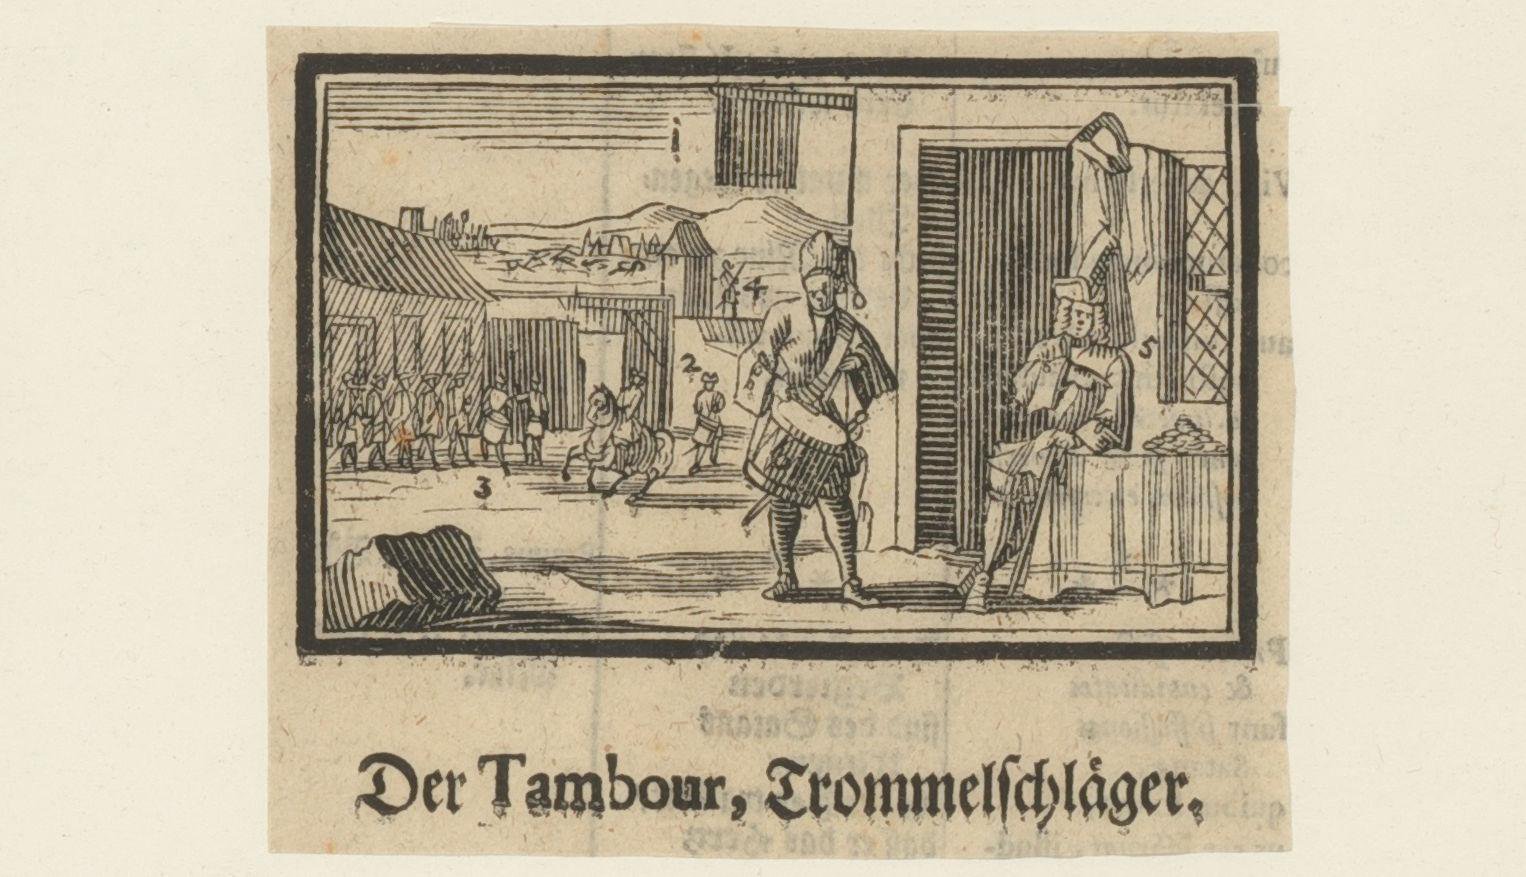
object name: book illustration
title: Der Tambour, Trommelschläger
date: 1719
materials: paper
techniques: letterpress printing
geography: nuremberg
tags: warfare; military affairs, the soldier; the soldier's life, drum (musical instrument) - cc - out of doors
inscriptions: stamp, collector's mark: Lugt 1641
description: Prent uit: Comenius, Johannes Amosius. Orbis sensualium picti pars prima (...). Neurenberg: Martin Endter, 1719, dl. 2, p. 284. Prent eerder gebruikt in: Comenius, Johannes Amosius. Orbis Sensualium Picti denuo aucti Pars Secunda (...). Neurenberg: Martin Endter, 1730, dl. 2.